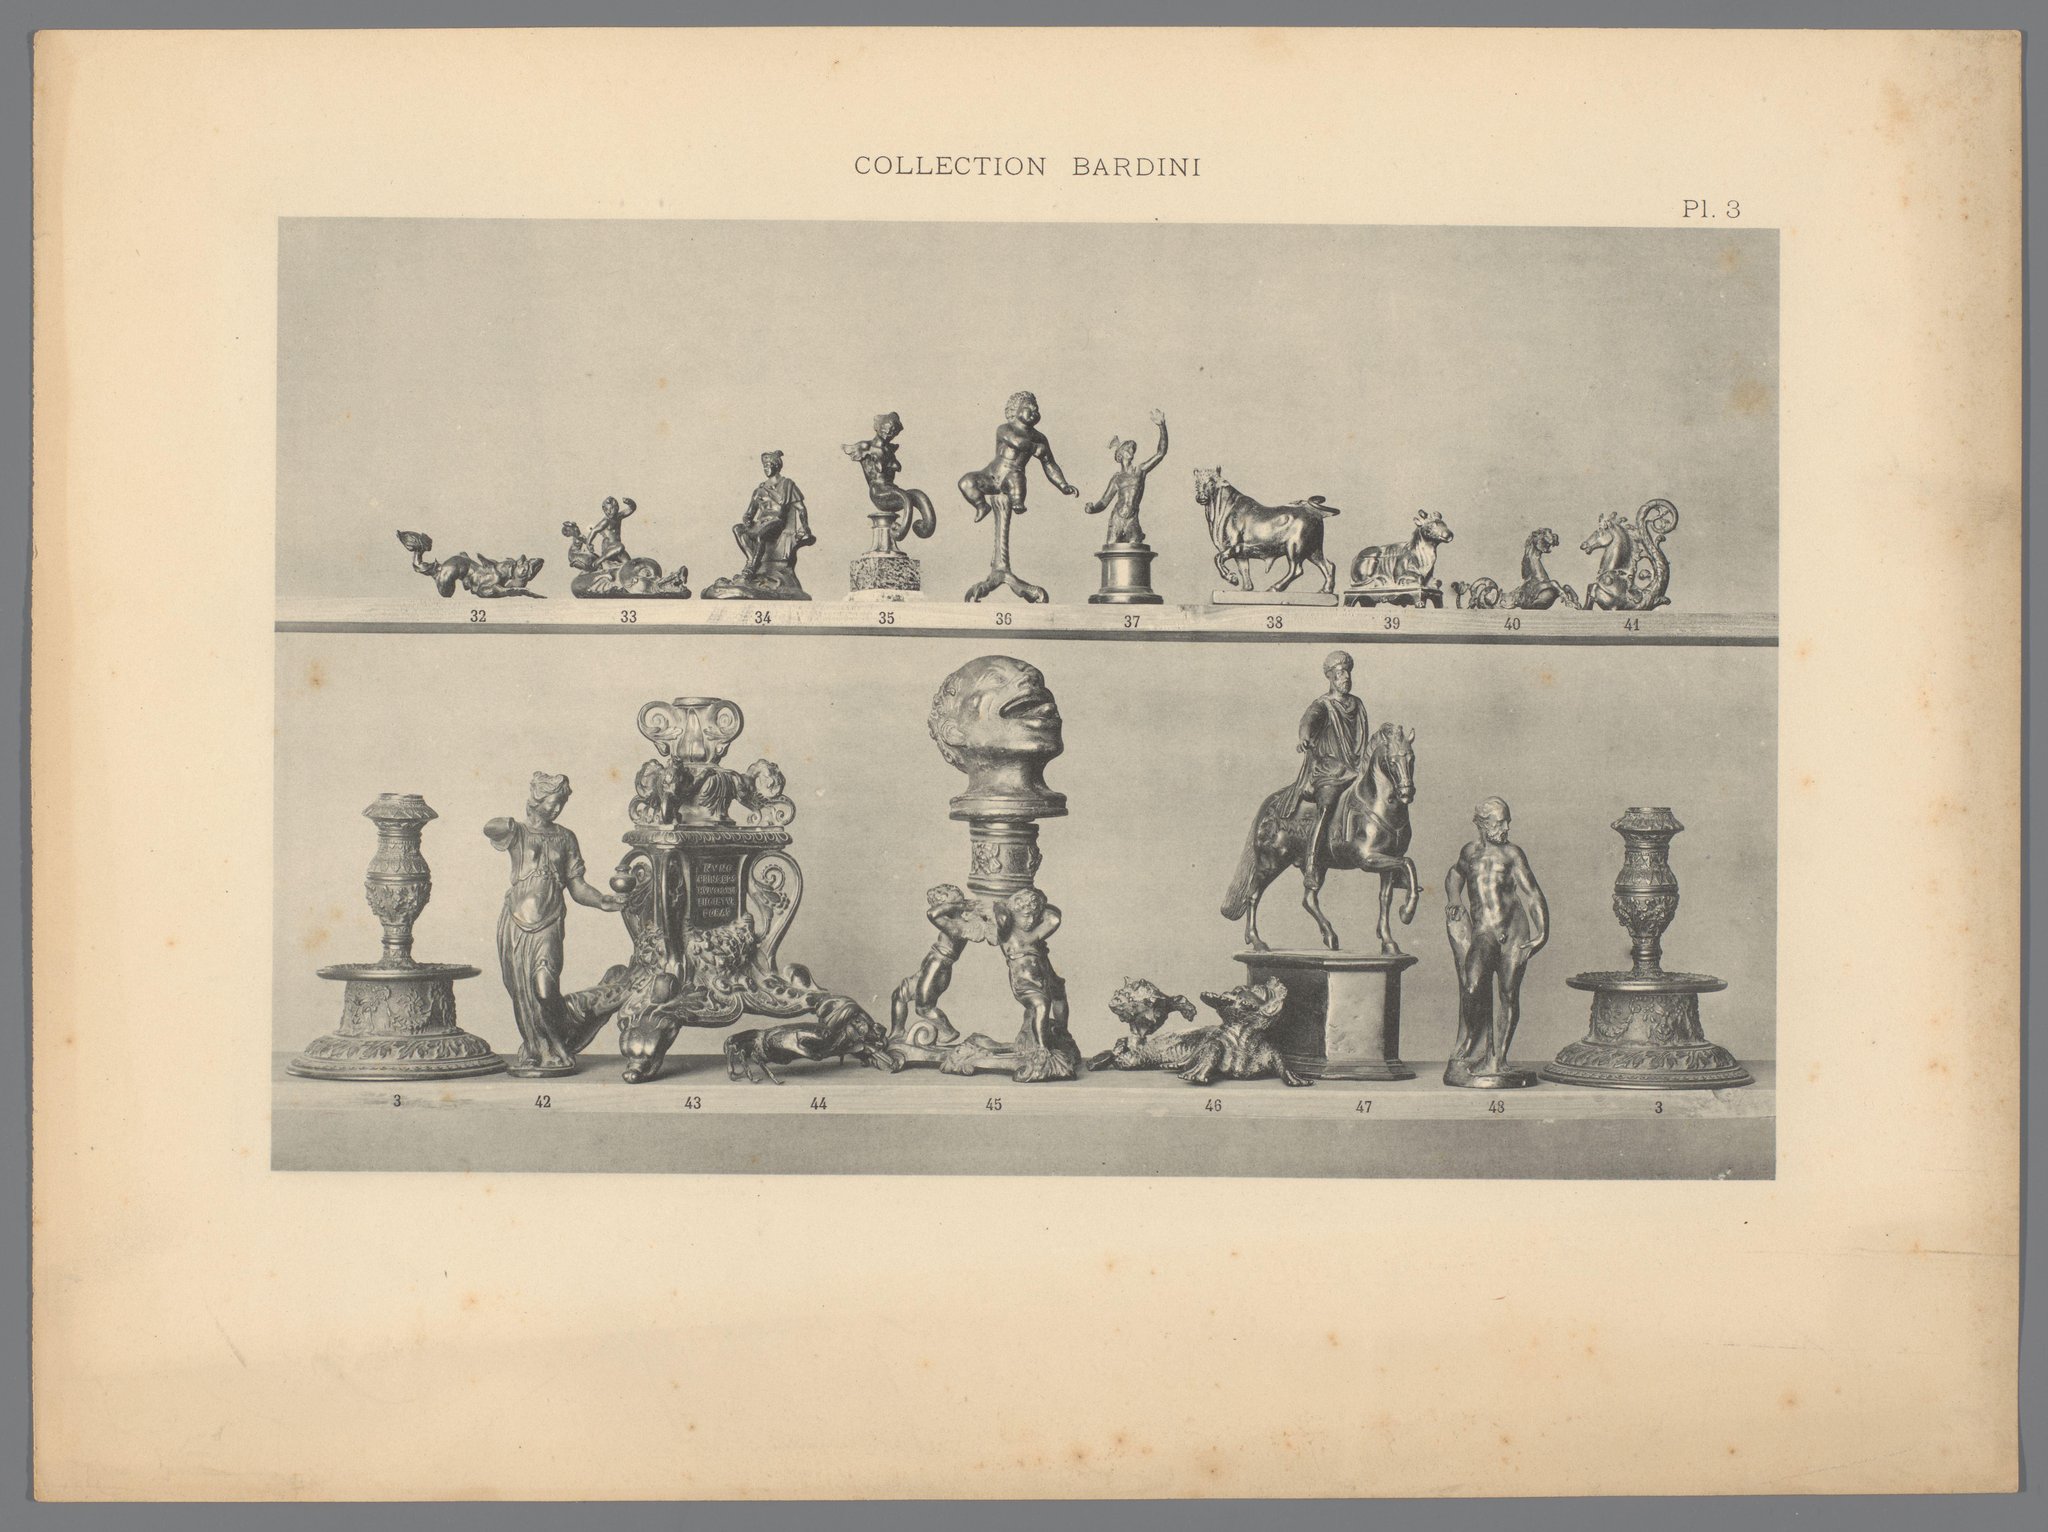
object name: photomechanical print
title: Opstelling van beeldjes in het Bardini Museum in Florence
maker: Anonymous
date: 1875-1930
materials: paper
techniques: photograph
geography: florence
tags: permanent exhibition, museum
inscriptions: number: ‘Pl. 3’